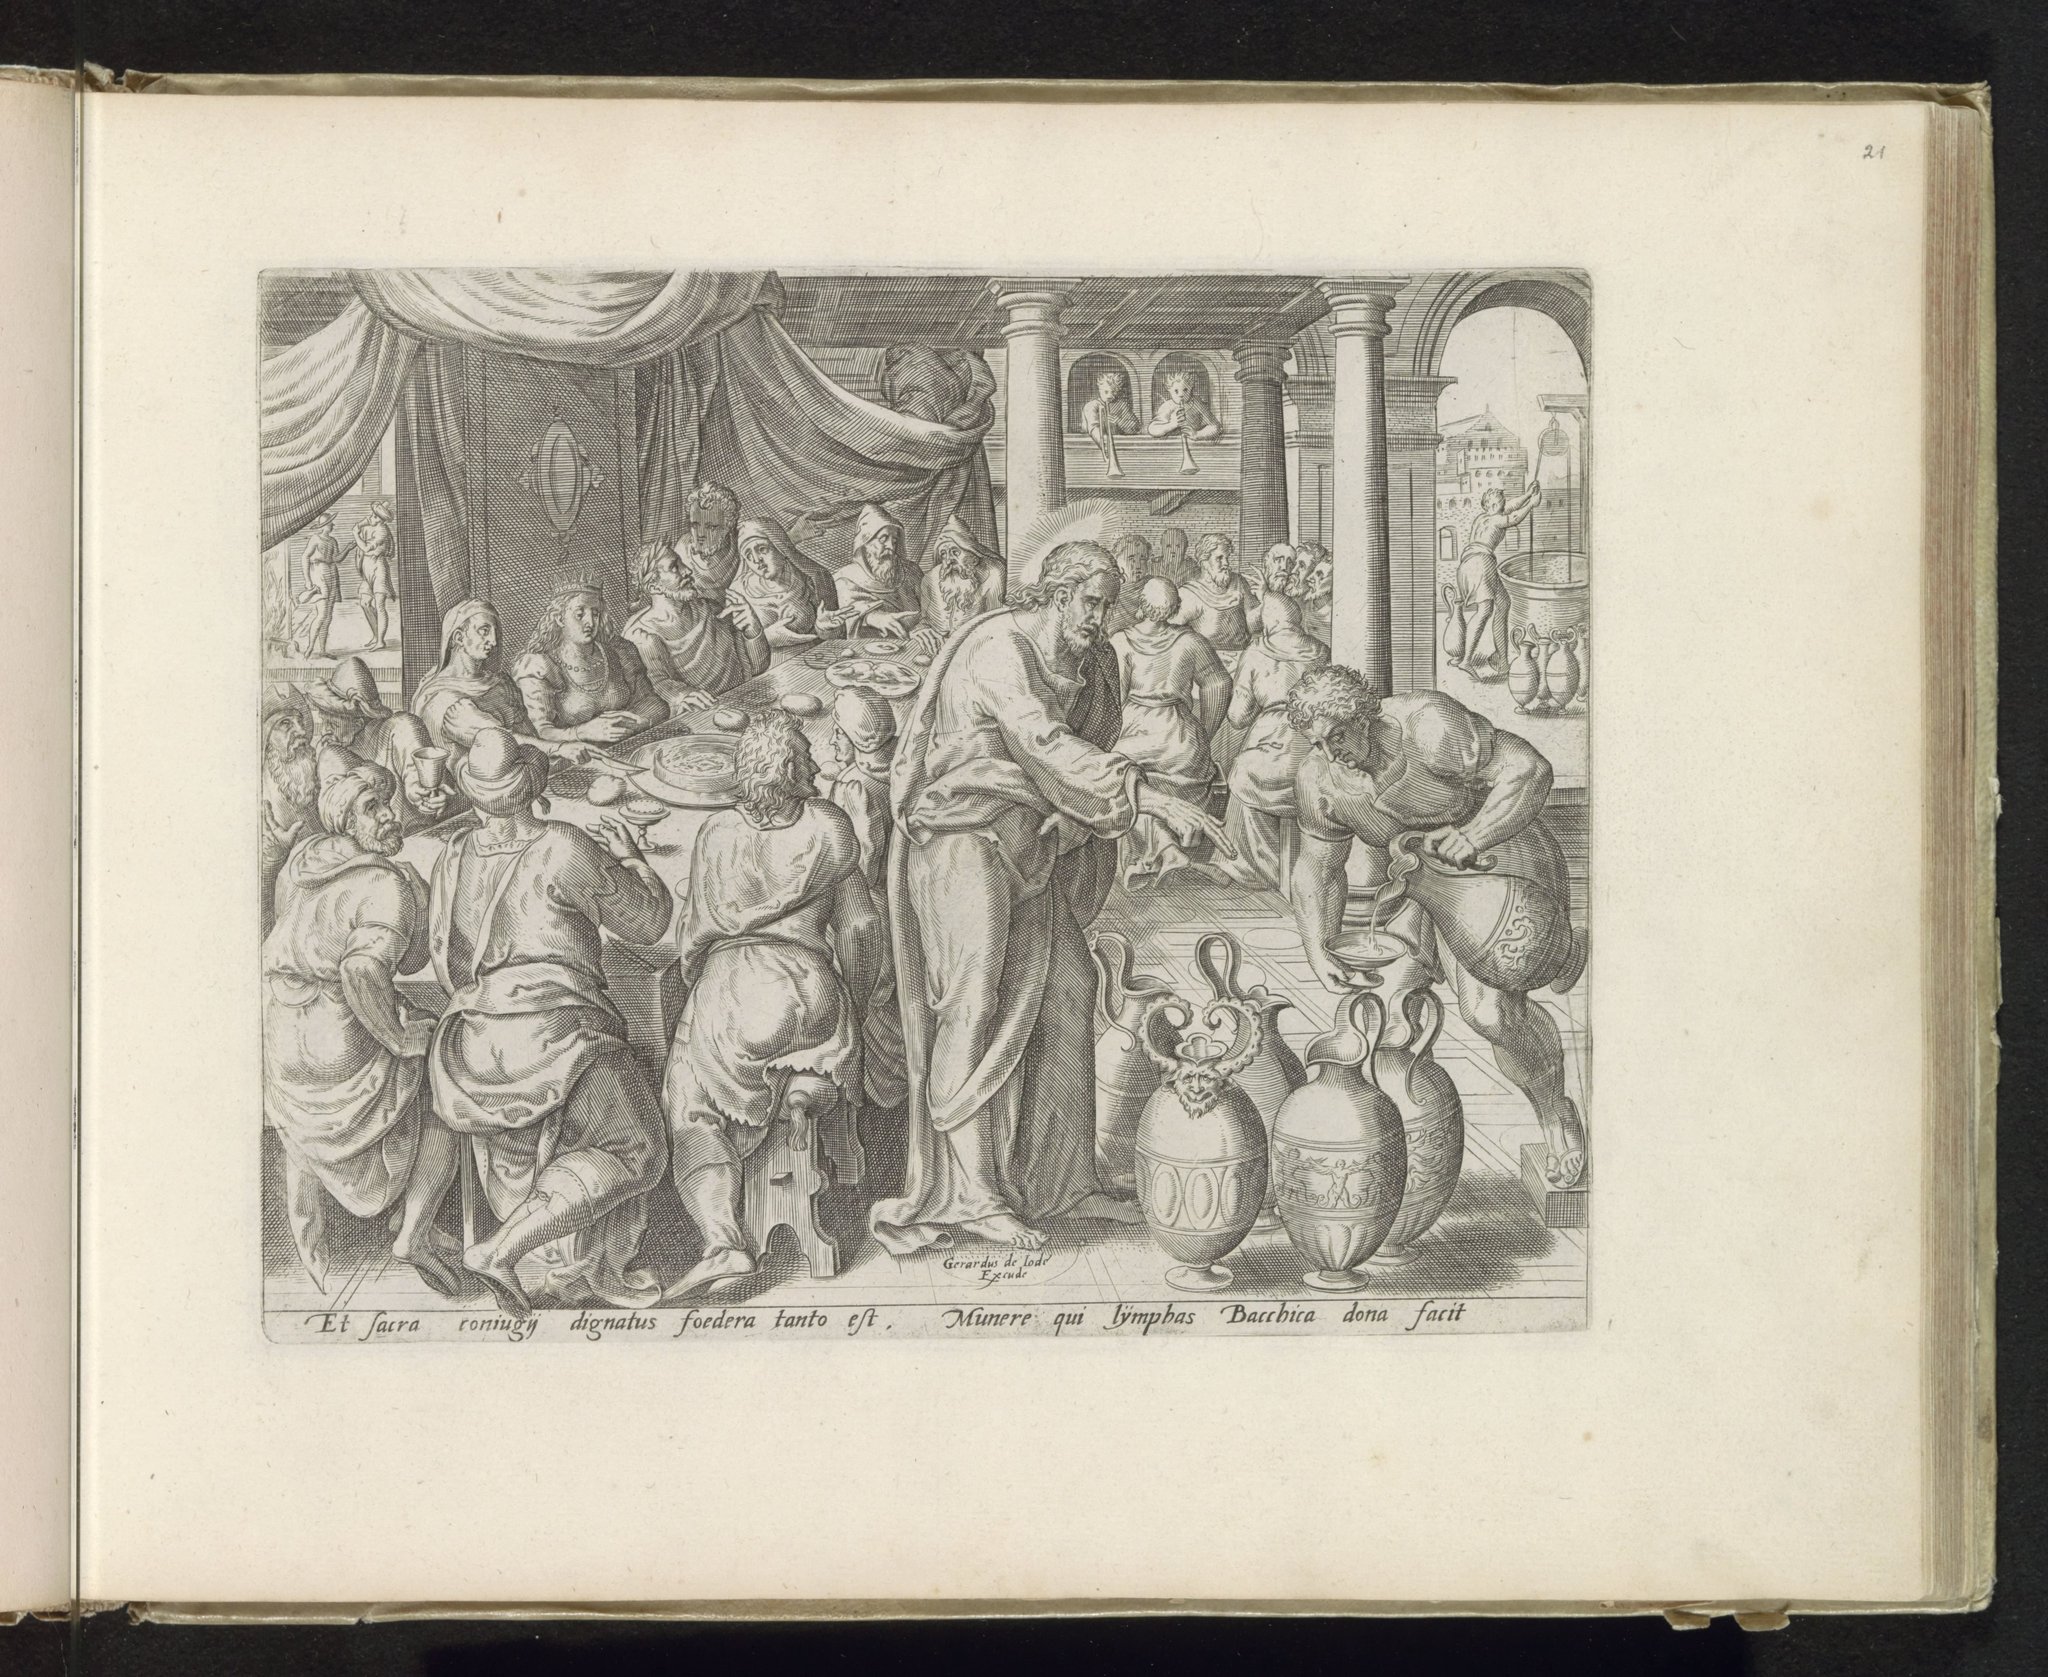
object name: album leaf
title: Thesaurus novi Testamenti elegantissimis iconibus expressus continens historias atque miracula doni nostri Iesu Christi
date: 1585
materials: paper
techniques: engraving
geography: antwerp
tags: the marriage-feast at cana (john 2:1-11)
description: Christus geeft op de bruiloft te Kana opdracht om kruiken met water te vullen. Het bruidspaar en de gasten zitten aan tafel. Maria zit links achter aan tafel. Links op de achtergrond proeft de ceremoniemeester van het water dat veranderd is in wijn. Onder de voorstelling een verwijzing in het Latijn naar de Bijbeltekst. Deze prent maakt deel uit van een album.